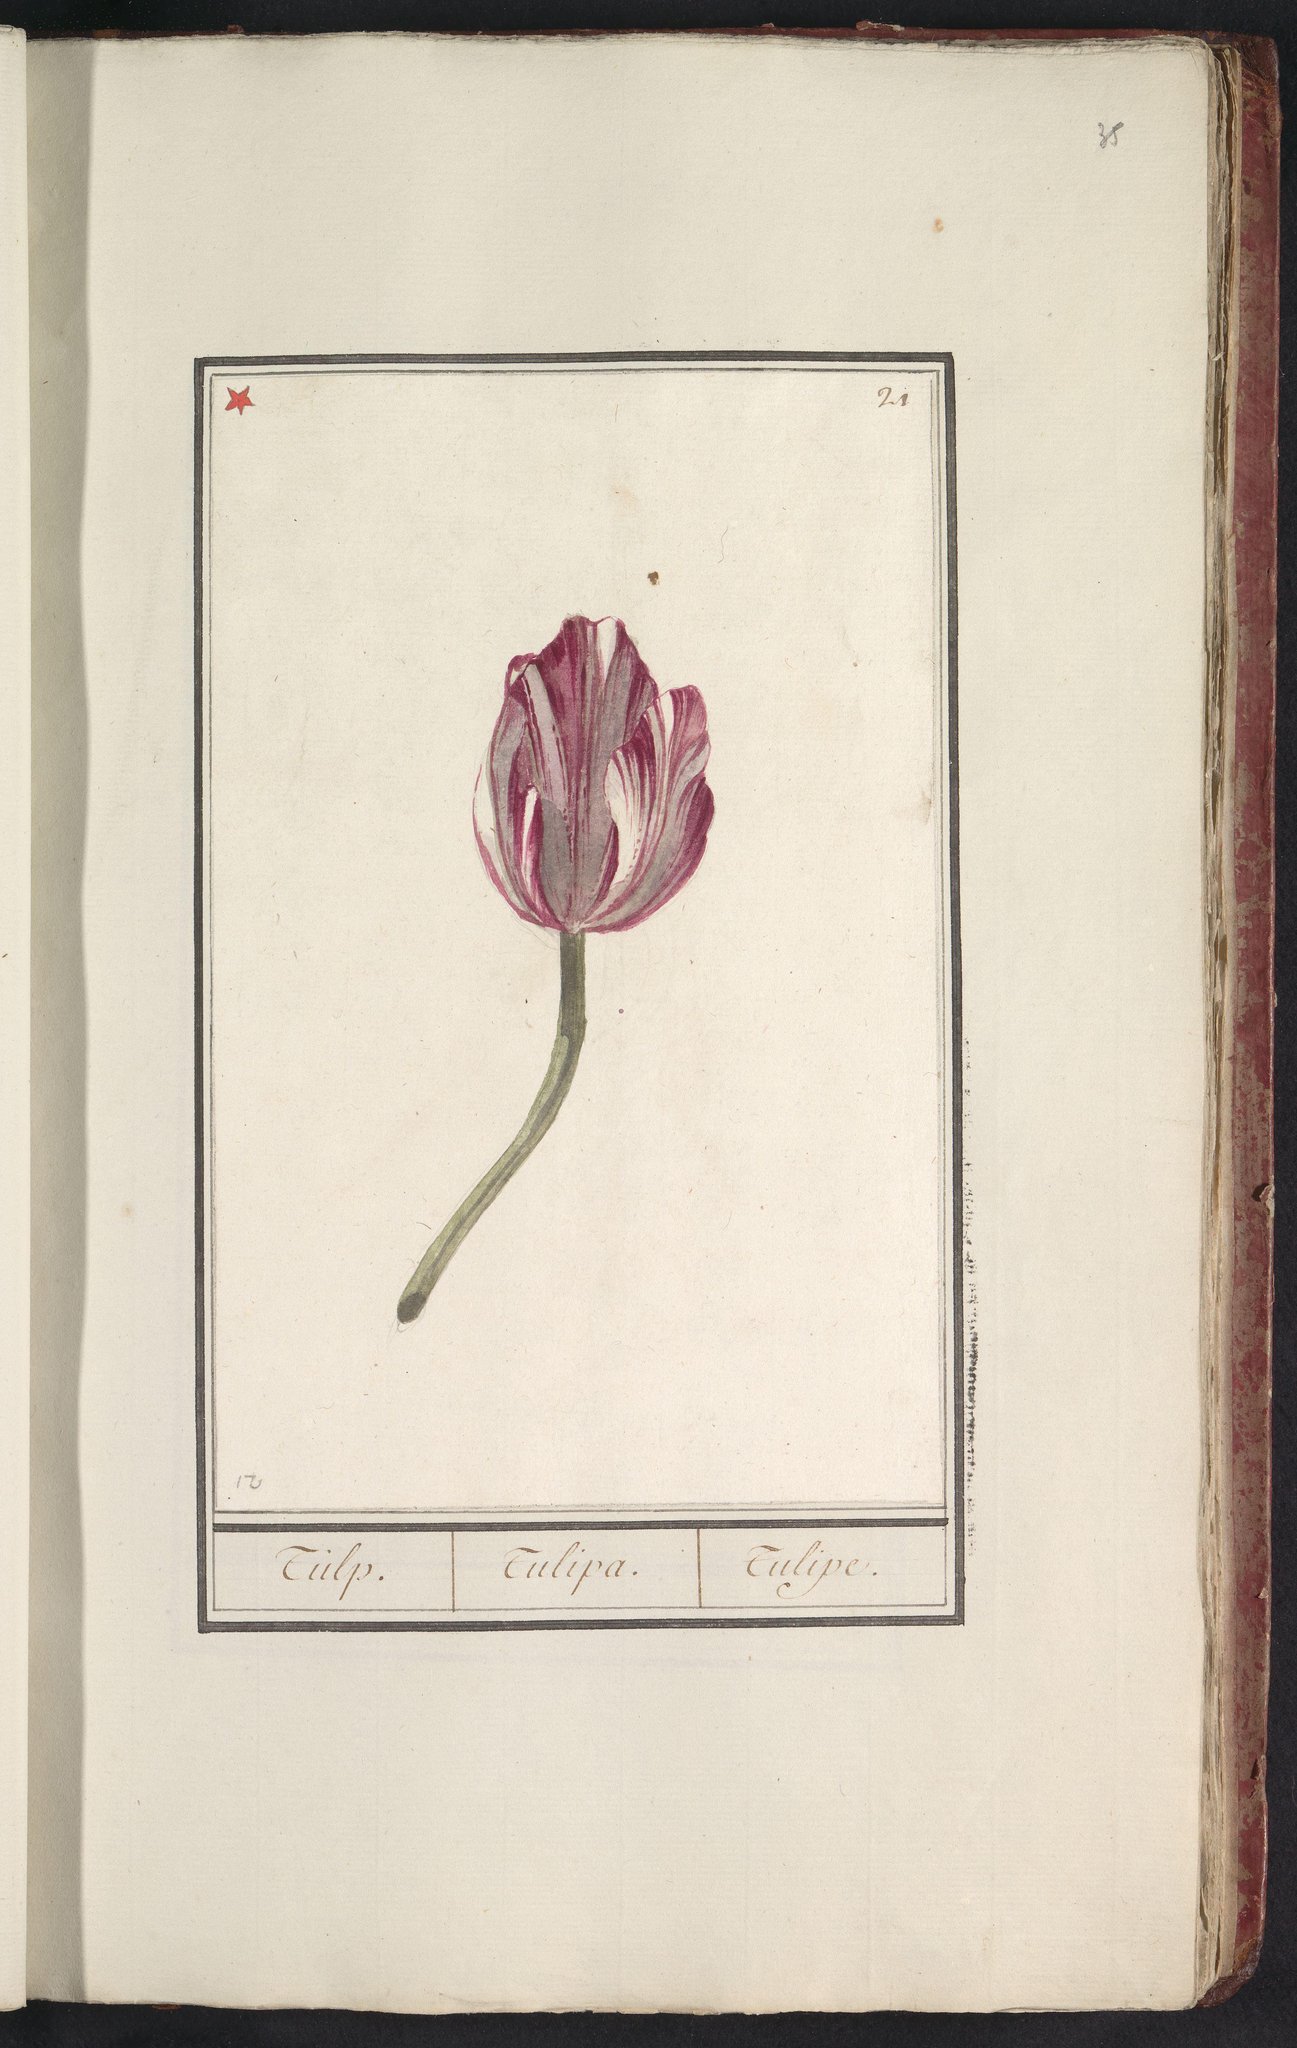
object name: drawing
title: Tulp. / Tulipa. / Tulipe.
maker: Anonymous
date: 1796-1814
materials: chalk, paint, paper, watercolor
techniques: brush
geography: southern netherlands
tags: flowers: tulip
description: Rood-witte tulp. Genummerd rechtsboven: 21. Linksboven gemerkt met een rood sterretje. Onderdeel van het eerste album met tekeningen van bloemen en planten. Achtste van twaalf albums met tekeningen van dieren, vogels en planten bekend rond 1600, gemaakt in opdracht van keizer Rudolf II. Met toelichting in Nederlands, Latijn en Frans.